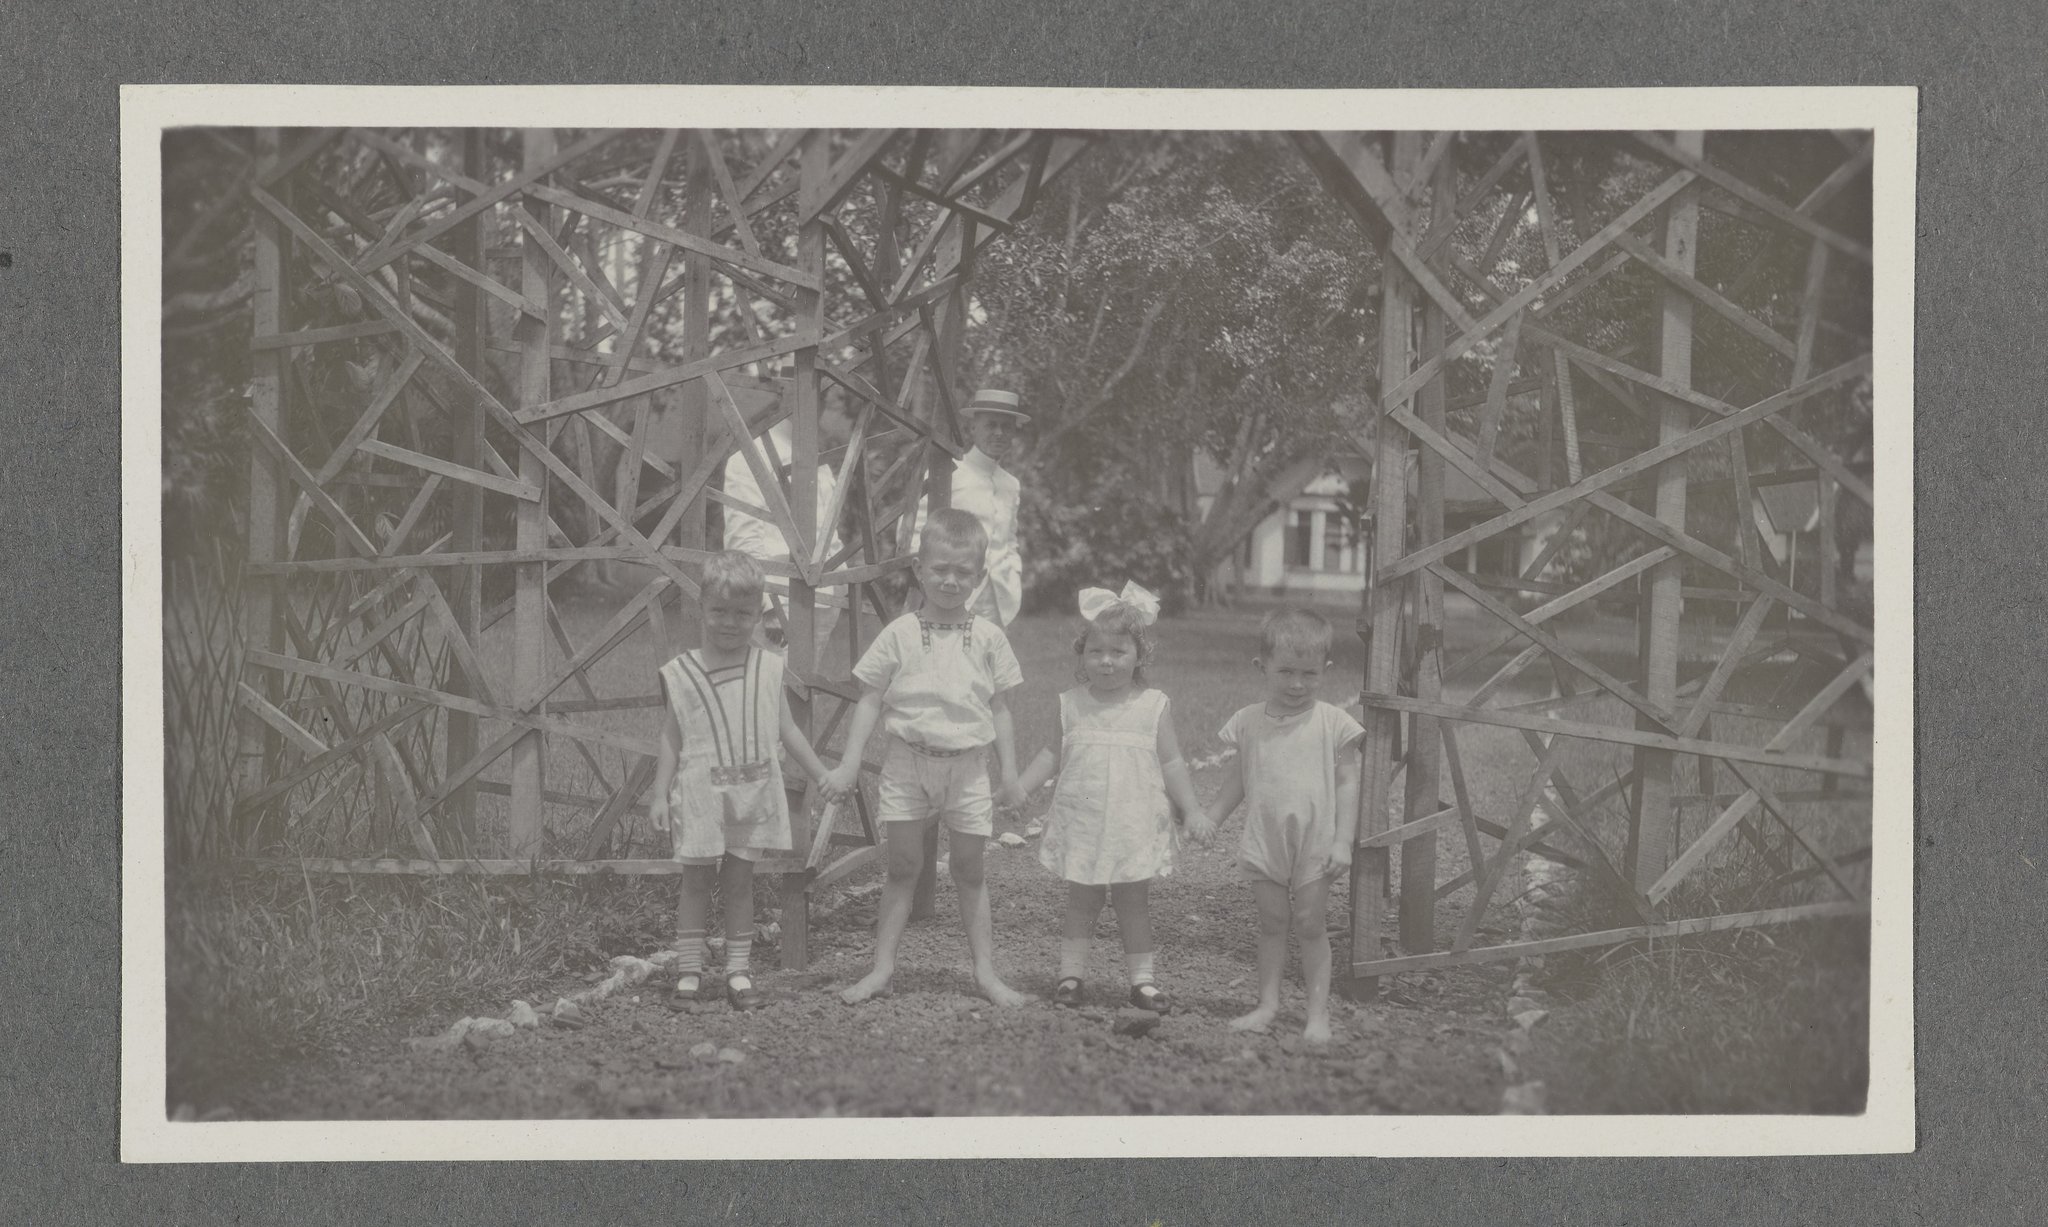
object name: photograph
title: Vier kinderen hand in hand voor een houten hekwerk in Batoedjadjar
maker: klaas kleiterp (i)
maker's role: arts, officier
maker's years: 1892-1943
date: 1901-1924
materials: paper, photographic support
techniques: gelatin silver print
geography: batoedjadjar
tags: child, gripping someone by the hand or the wrist; clasped hands, dutch east indies, the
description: Eerste en derde van links resp. Klaas en Tiny Kleiterp. Onderdeel van Fotoalbum van de familie Kleiterp-Vermeulen met opnames van de kinderen Klaas en Tiny in Nederlands-Indië.